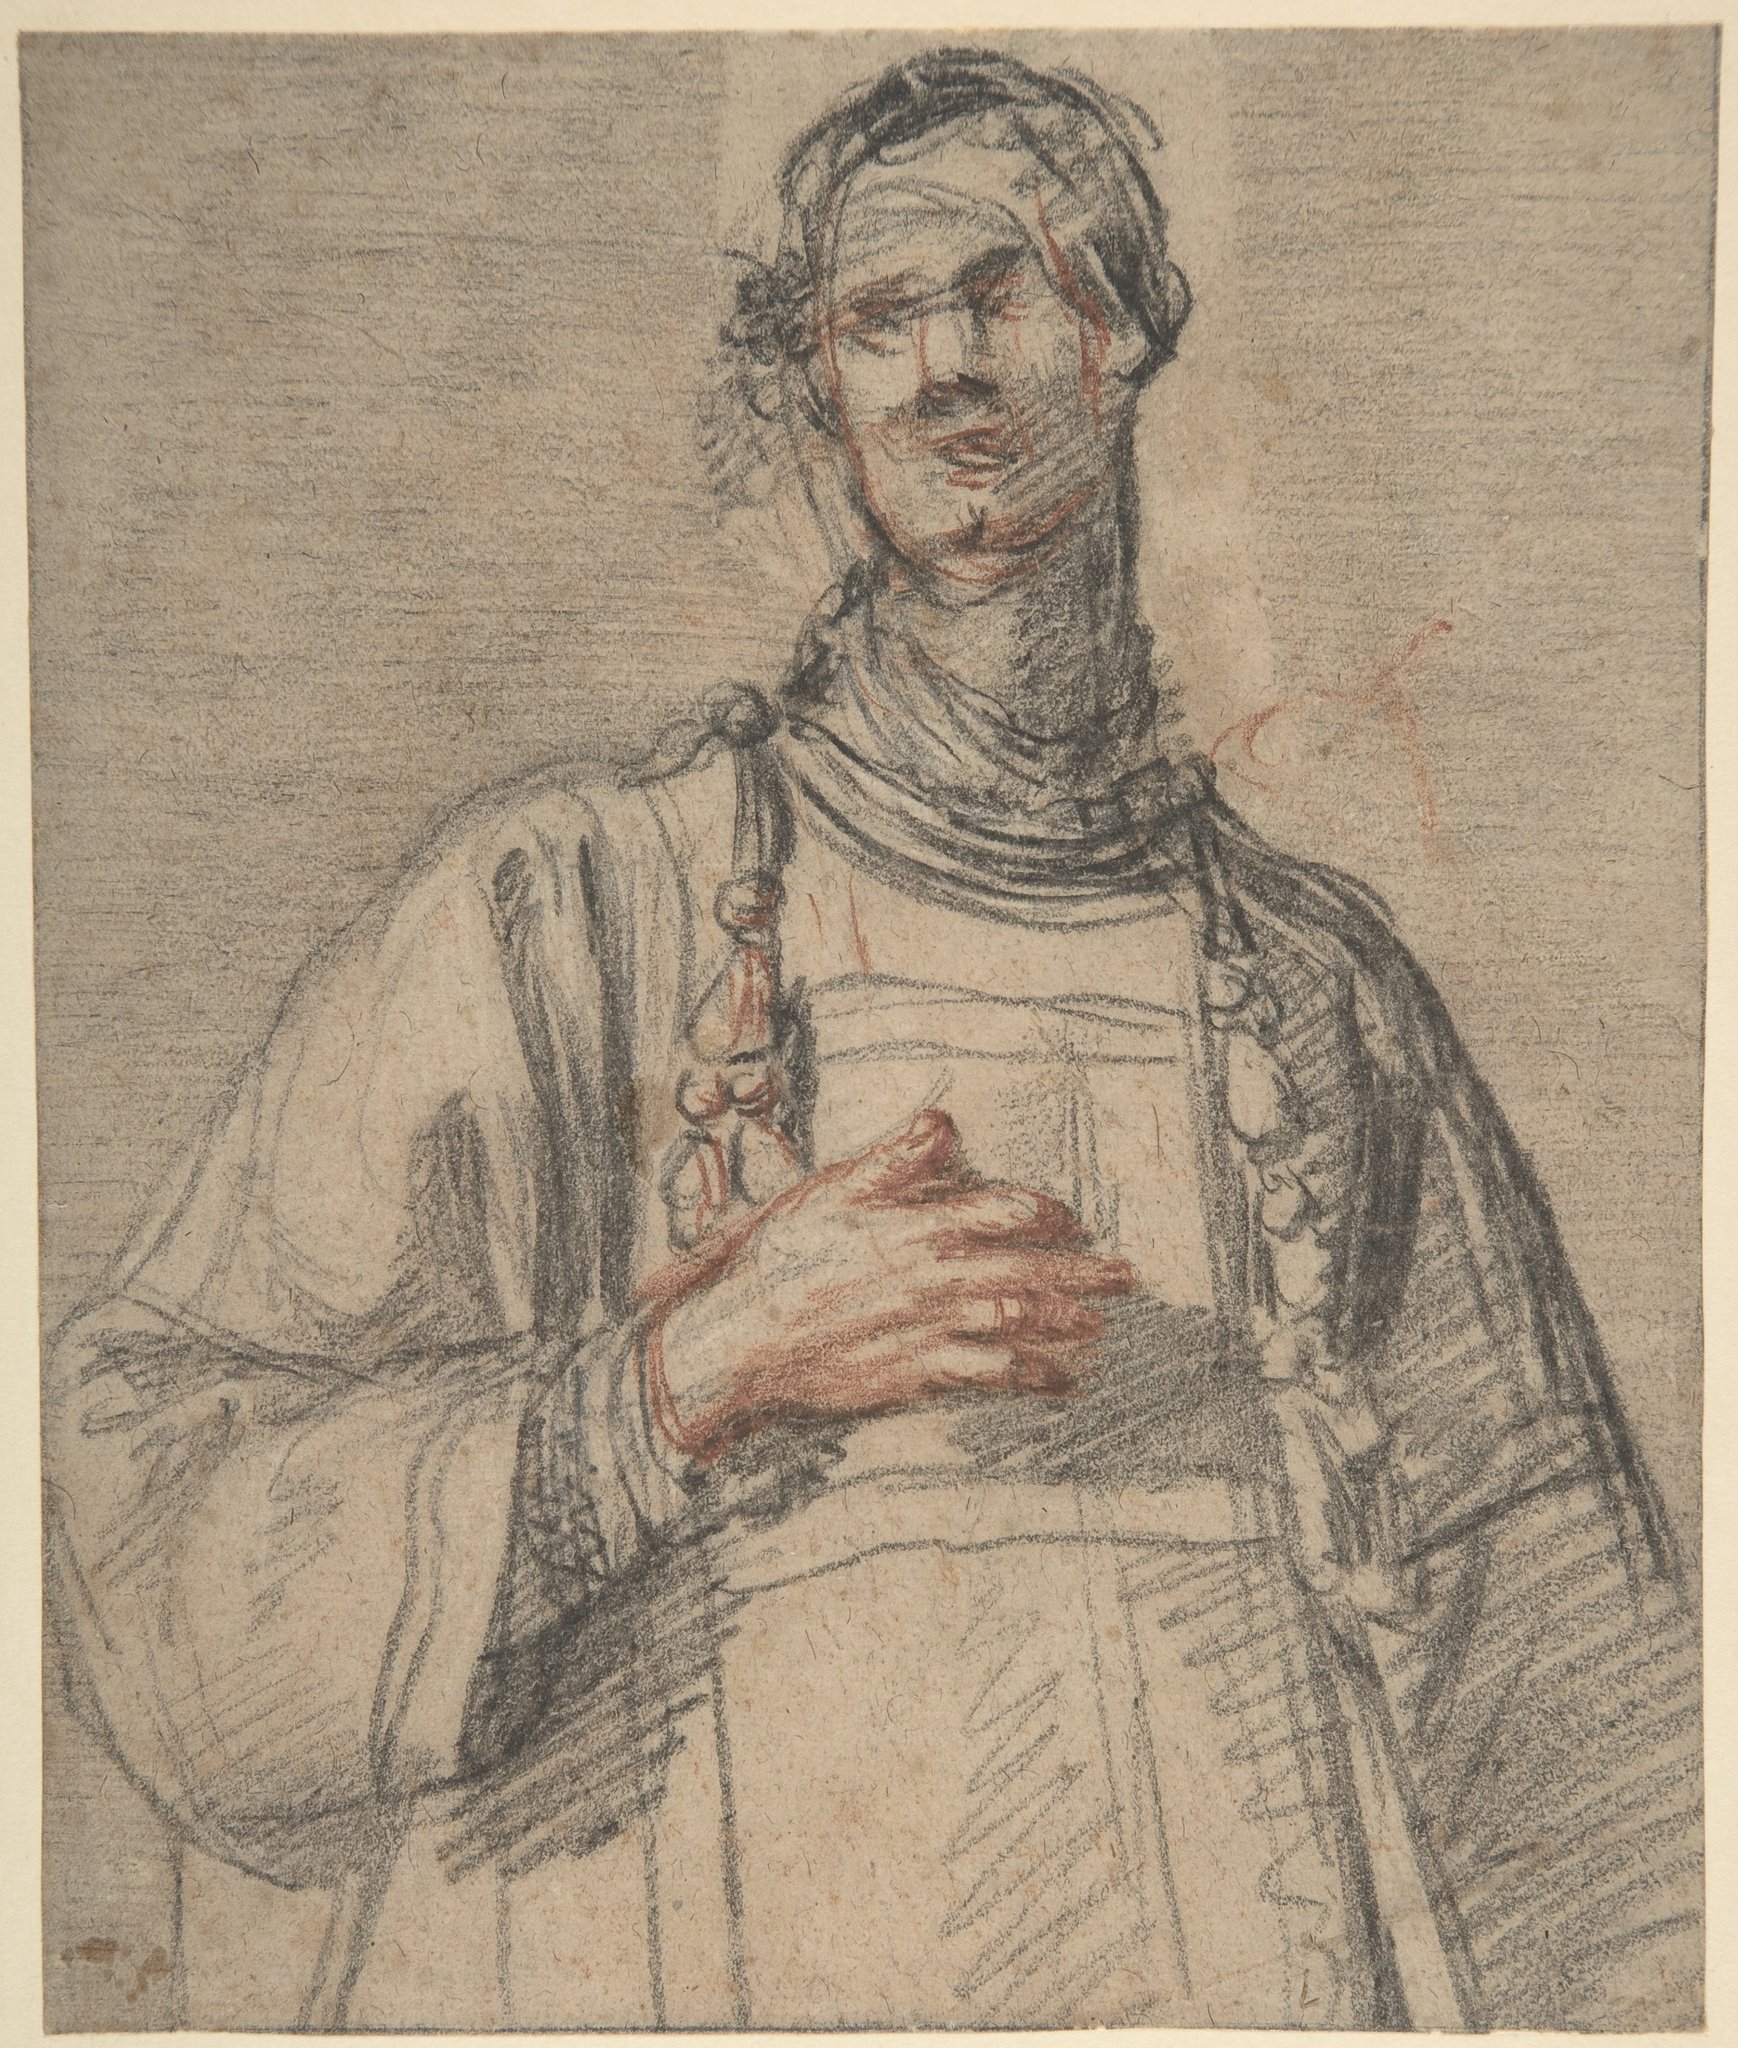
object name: drawing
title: Figure of a Cleric in Half-Length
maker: jacopo confortini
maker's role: artist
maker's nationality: italian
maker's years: 1602-1672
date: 1600-1699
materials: chalk, paper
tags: men